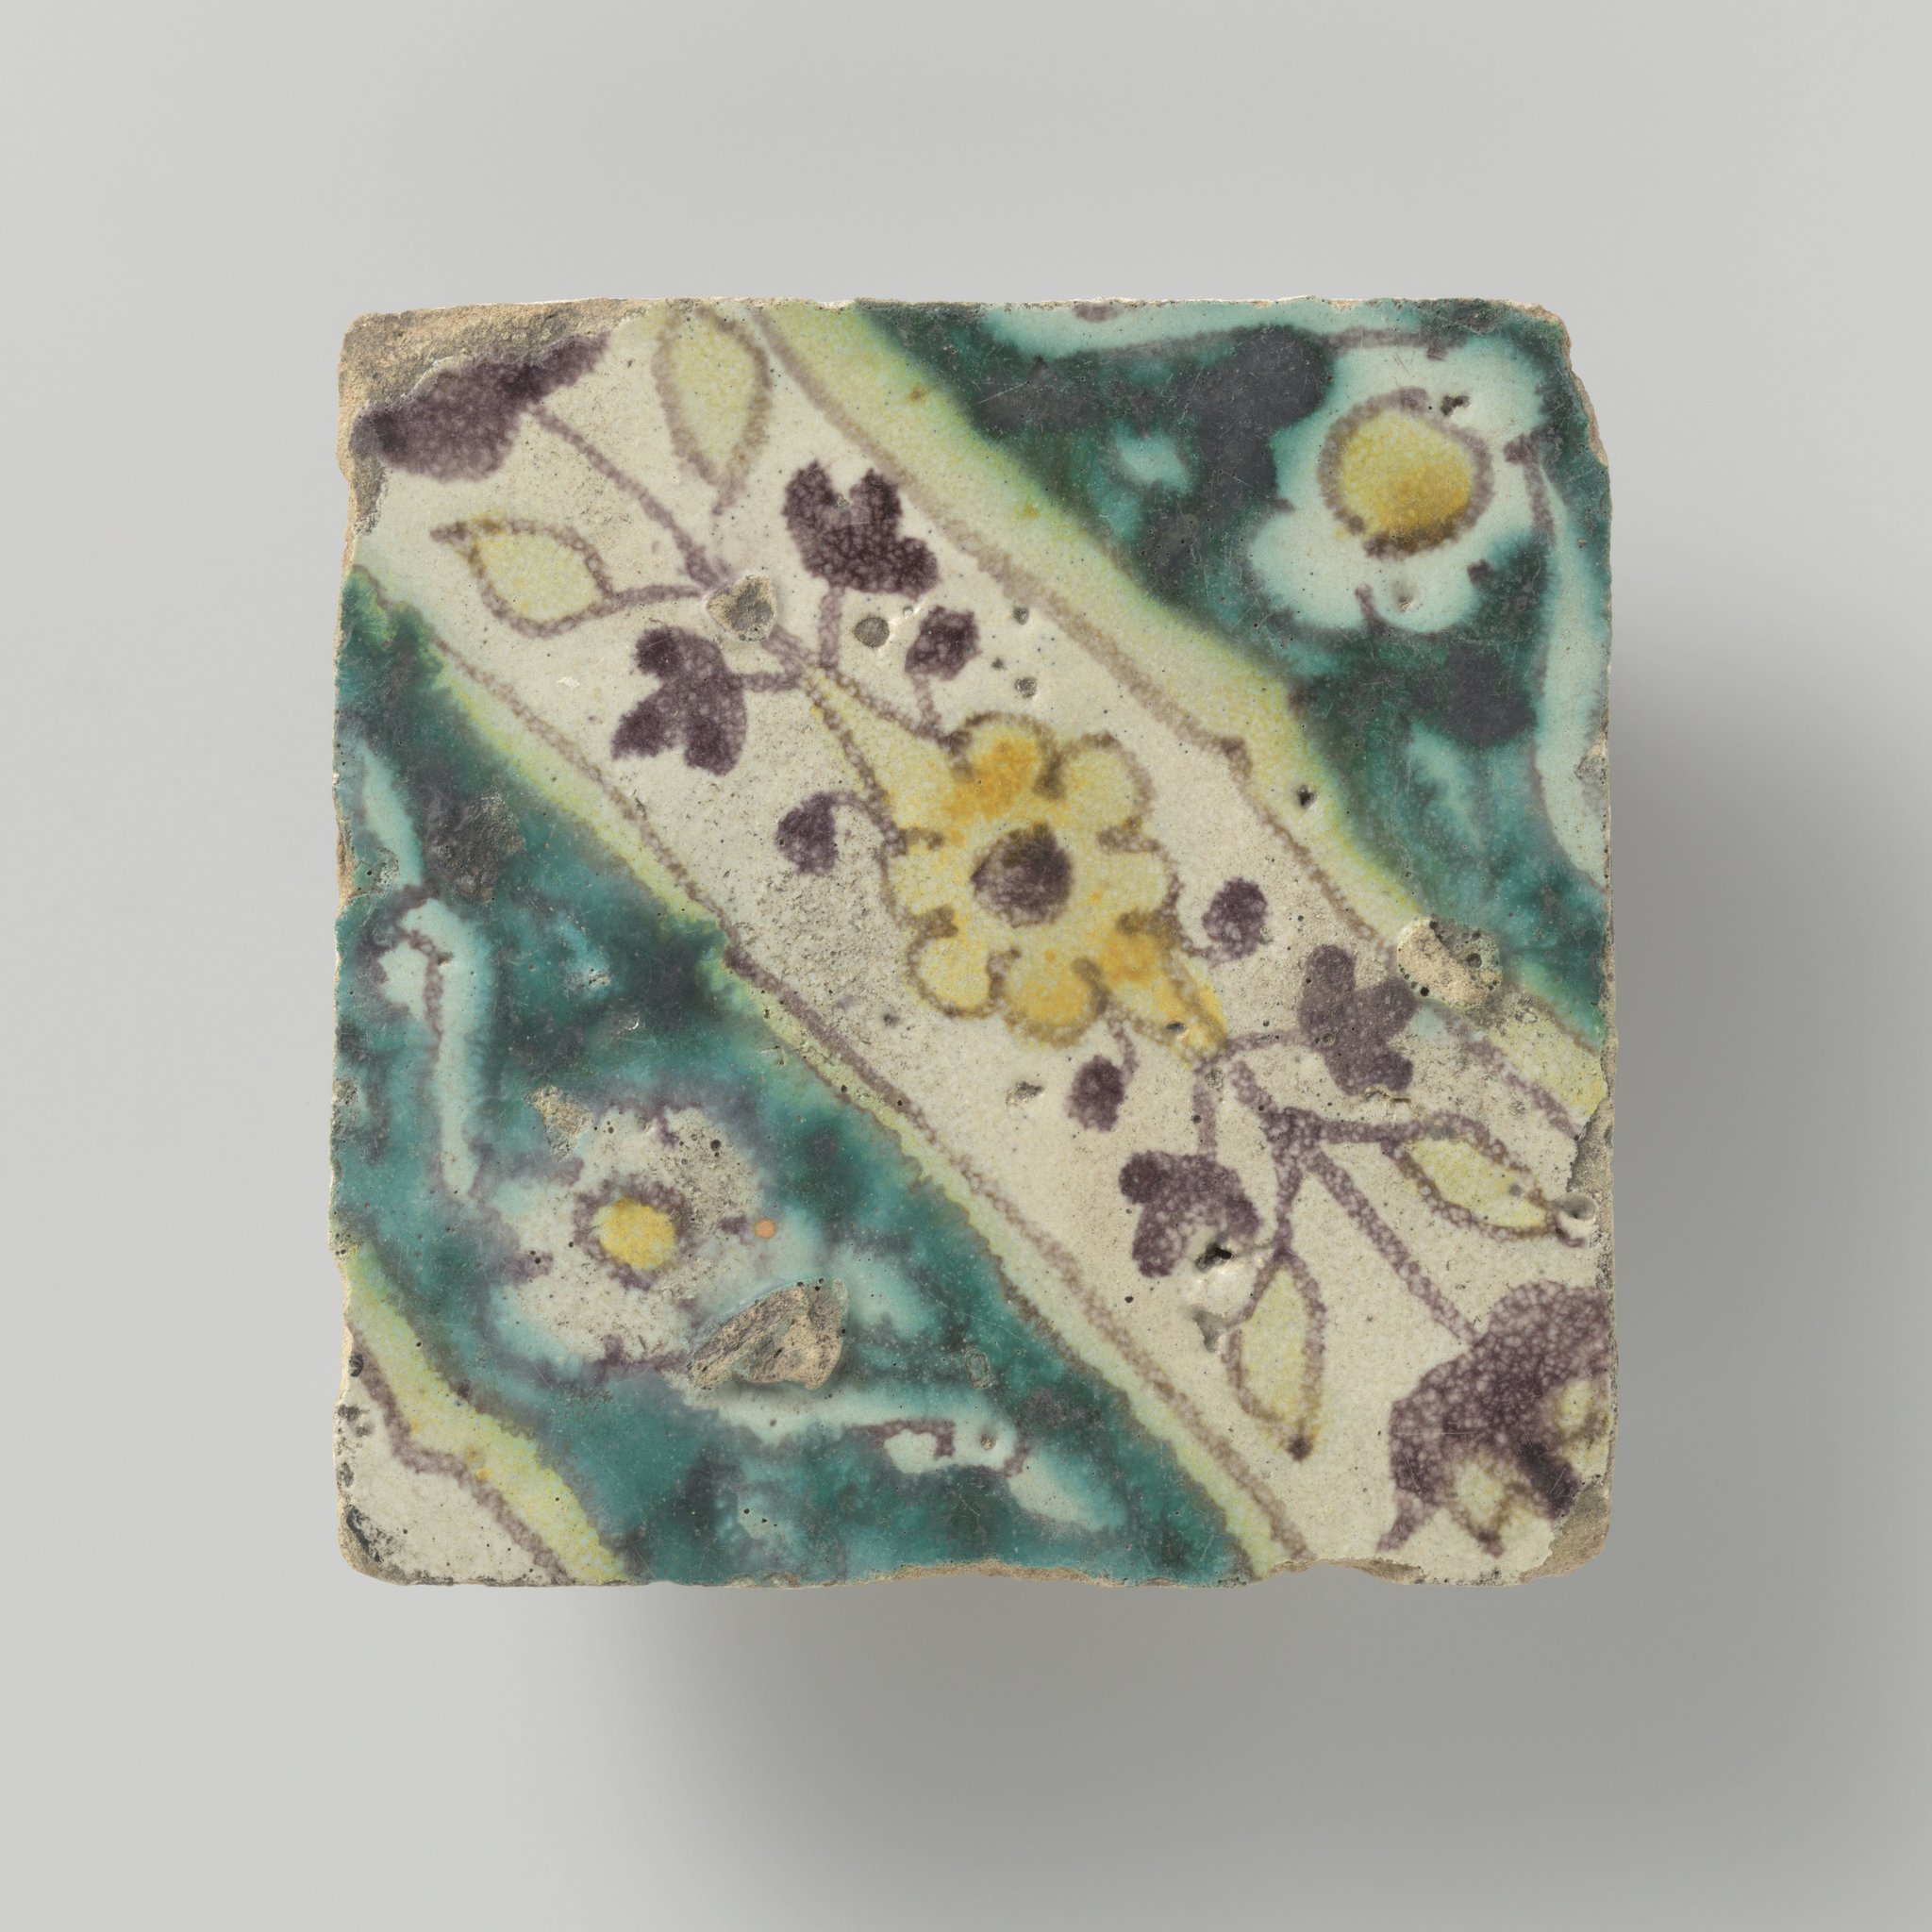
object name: tile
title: Tegel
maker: Anonymous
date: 1700-1850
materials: earthenware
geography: maghreb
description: Tegel beschilderd met een bloemrank diagonaal geplaatst.